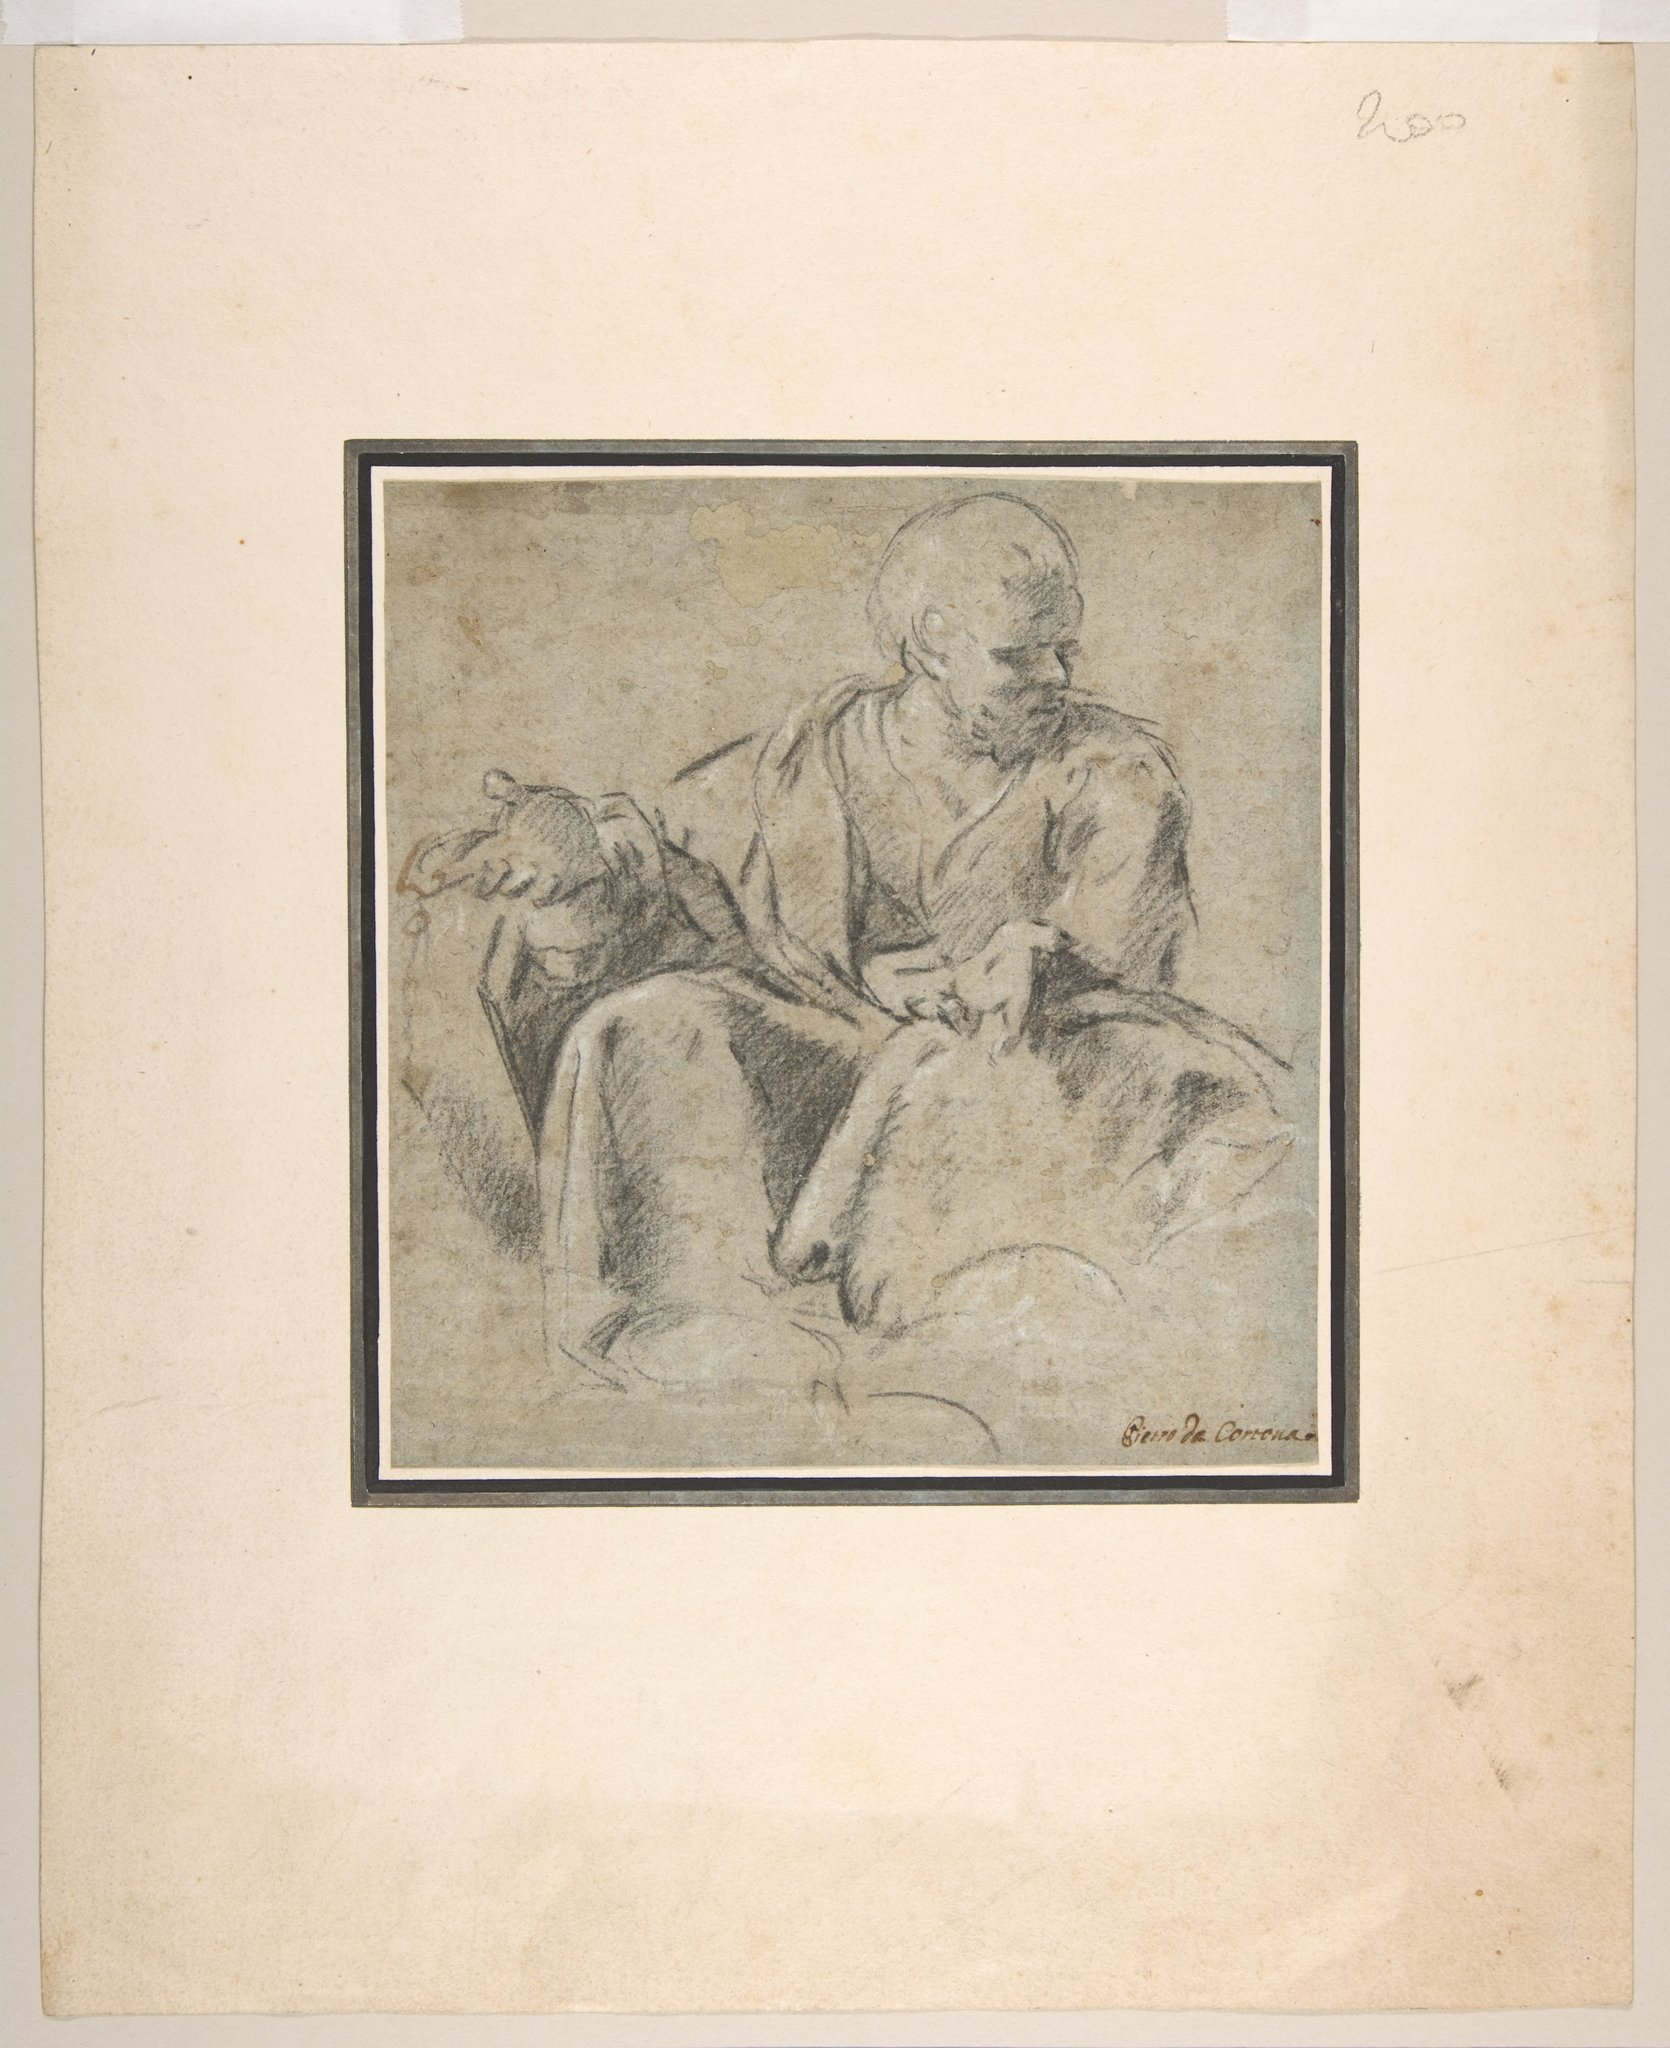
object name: drawing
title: Study for a Figure of Saint Joseph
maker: bartolomeo schedoni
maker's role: artist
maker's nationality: italian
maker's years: 1578-1615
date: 1595-1615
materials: chalk, gouache, paper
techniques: highlighting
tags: men,saints